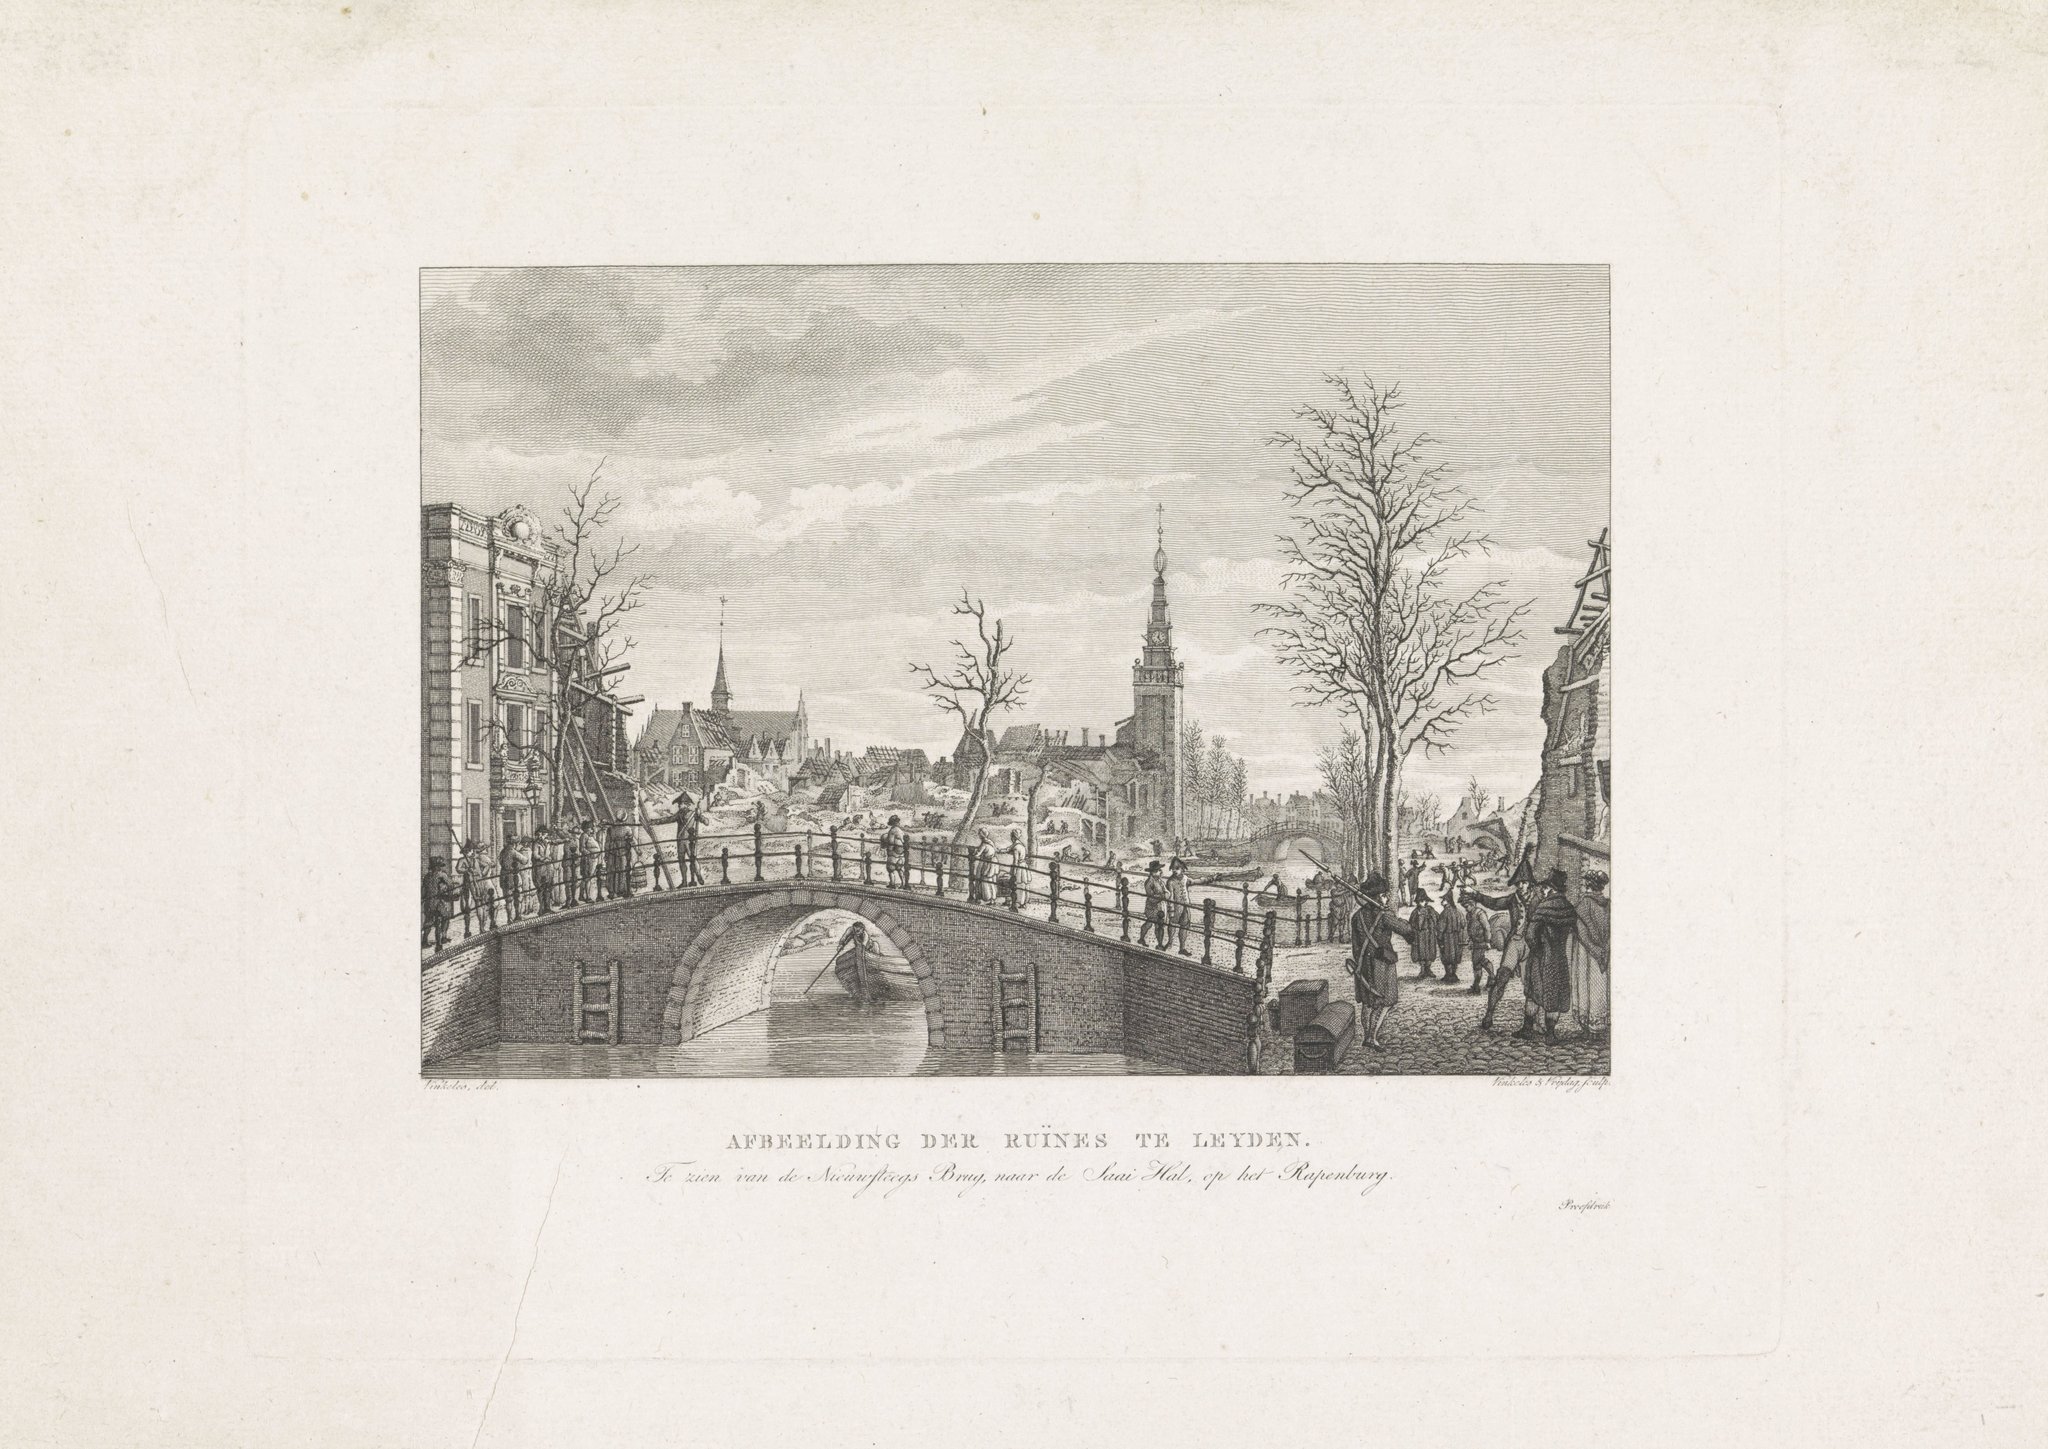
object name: print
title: Herstelwerk op het Rapenburg na de ramp, 1807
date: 1807-1808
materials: paper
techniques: engraving, etching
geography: netherlands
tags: gunpowder disaster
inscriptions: collector's mark: Lugt 2228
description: Onderdeel van een serie van vier platen apart verschenen in een map met de titel 'Vier afbeeldingen betrekkelyk tot Leydens ramp, op den twaalfden January MDCCCVII' en de namen van de uitgevers Joh: Allart en Jac: Ruys (dit omslag ontbreekt hier) en ook gebruikt als illustratie in: Willem Bilderdijk en Matthys Siegenbeek, Leydens ramp. Amsterdam: Joh. Allart, 1808.